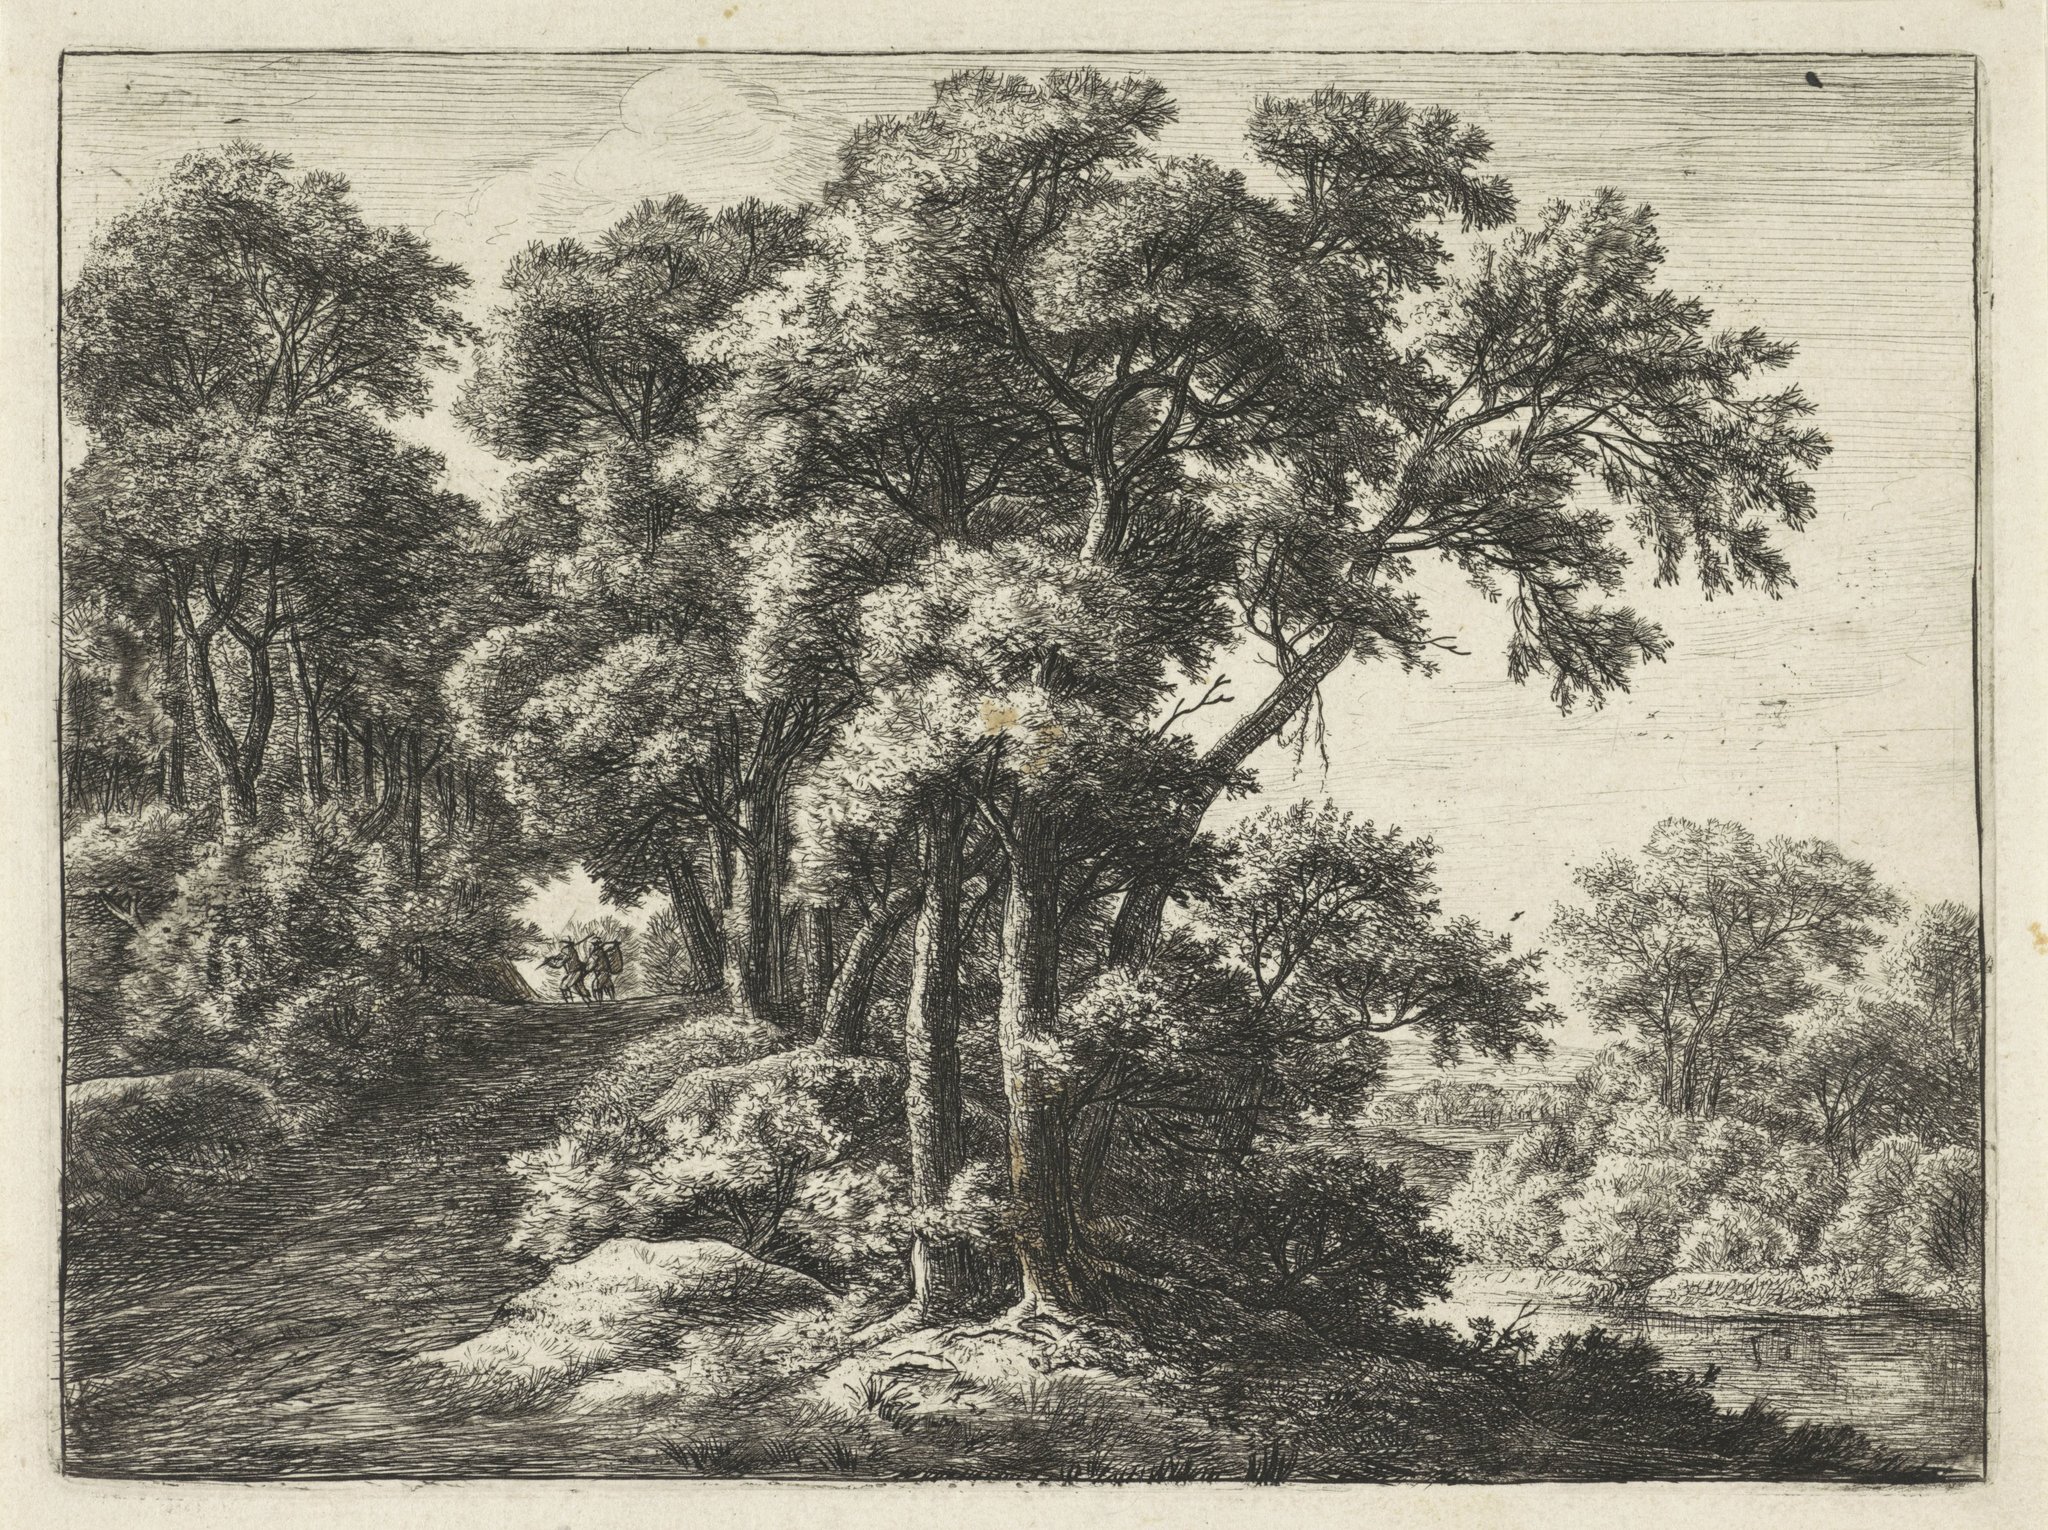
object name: print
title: Landweg langs een rivier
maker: anthonie waterloo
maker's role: draughtsman, painter, print maker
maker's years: 1609-1690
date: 1630-1663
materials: paper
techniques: etching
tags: low hill country, river, pedlar, road, path, 'en route', traveller under way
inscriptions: collector's mark: Lugt 240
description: Rechts stroomt een rivier. Links voert een steile landweg tussen enkele bomen door. In de verte zijn een wandelaar en een marskramer weergegeven.